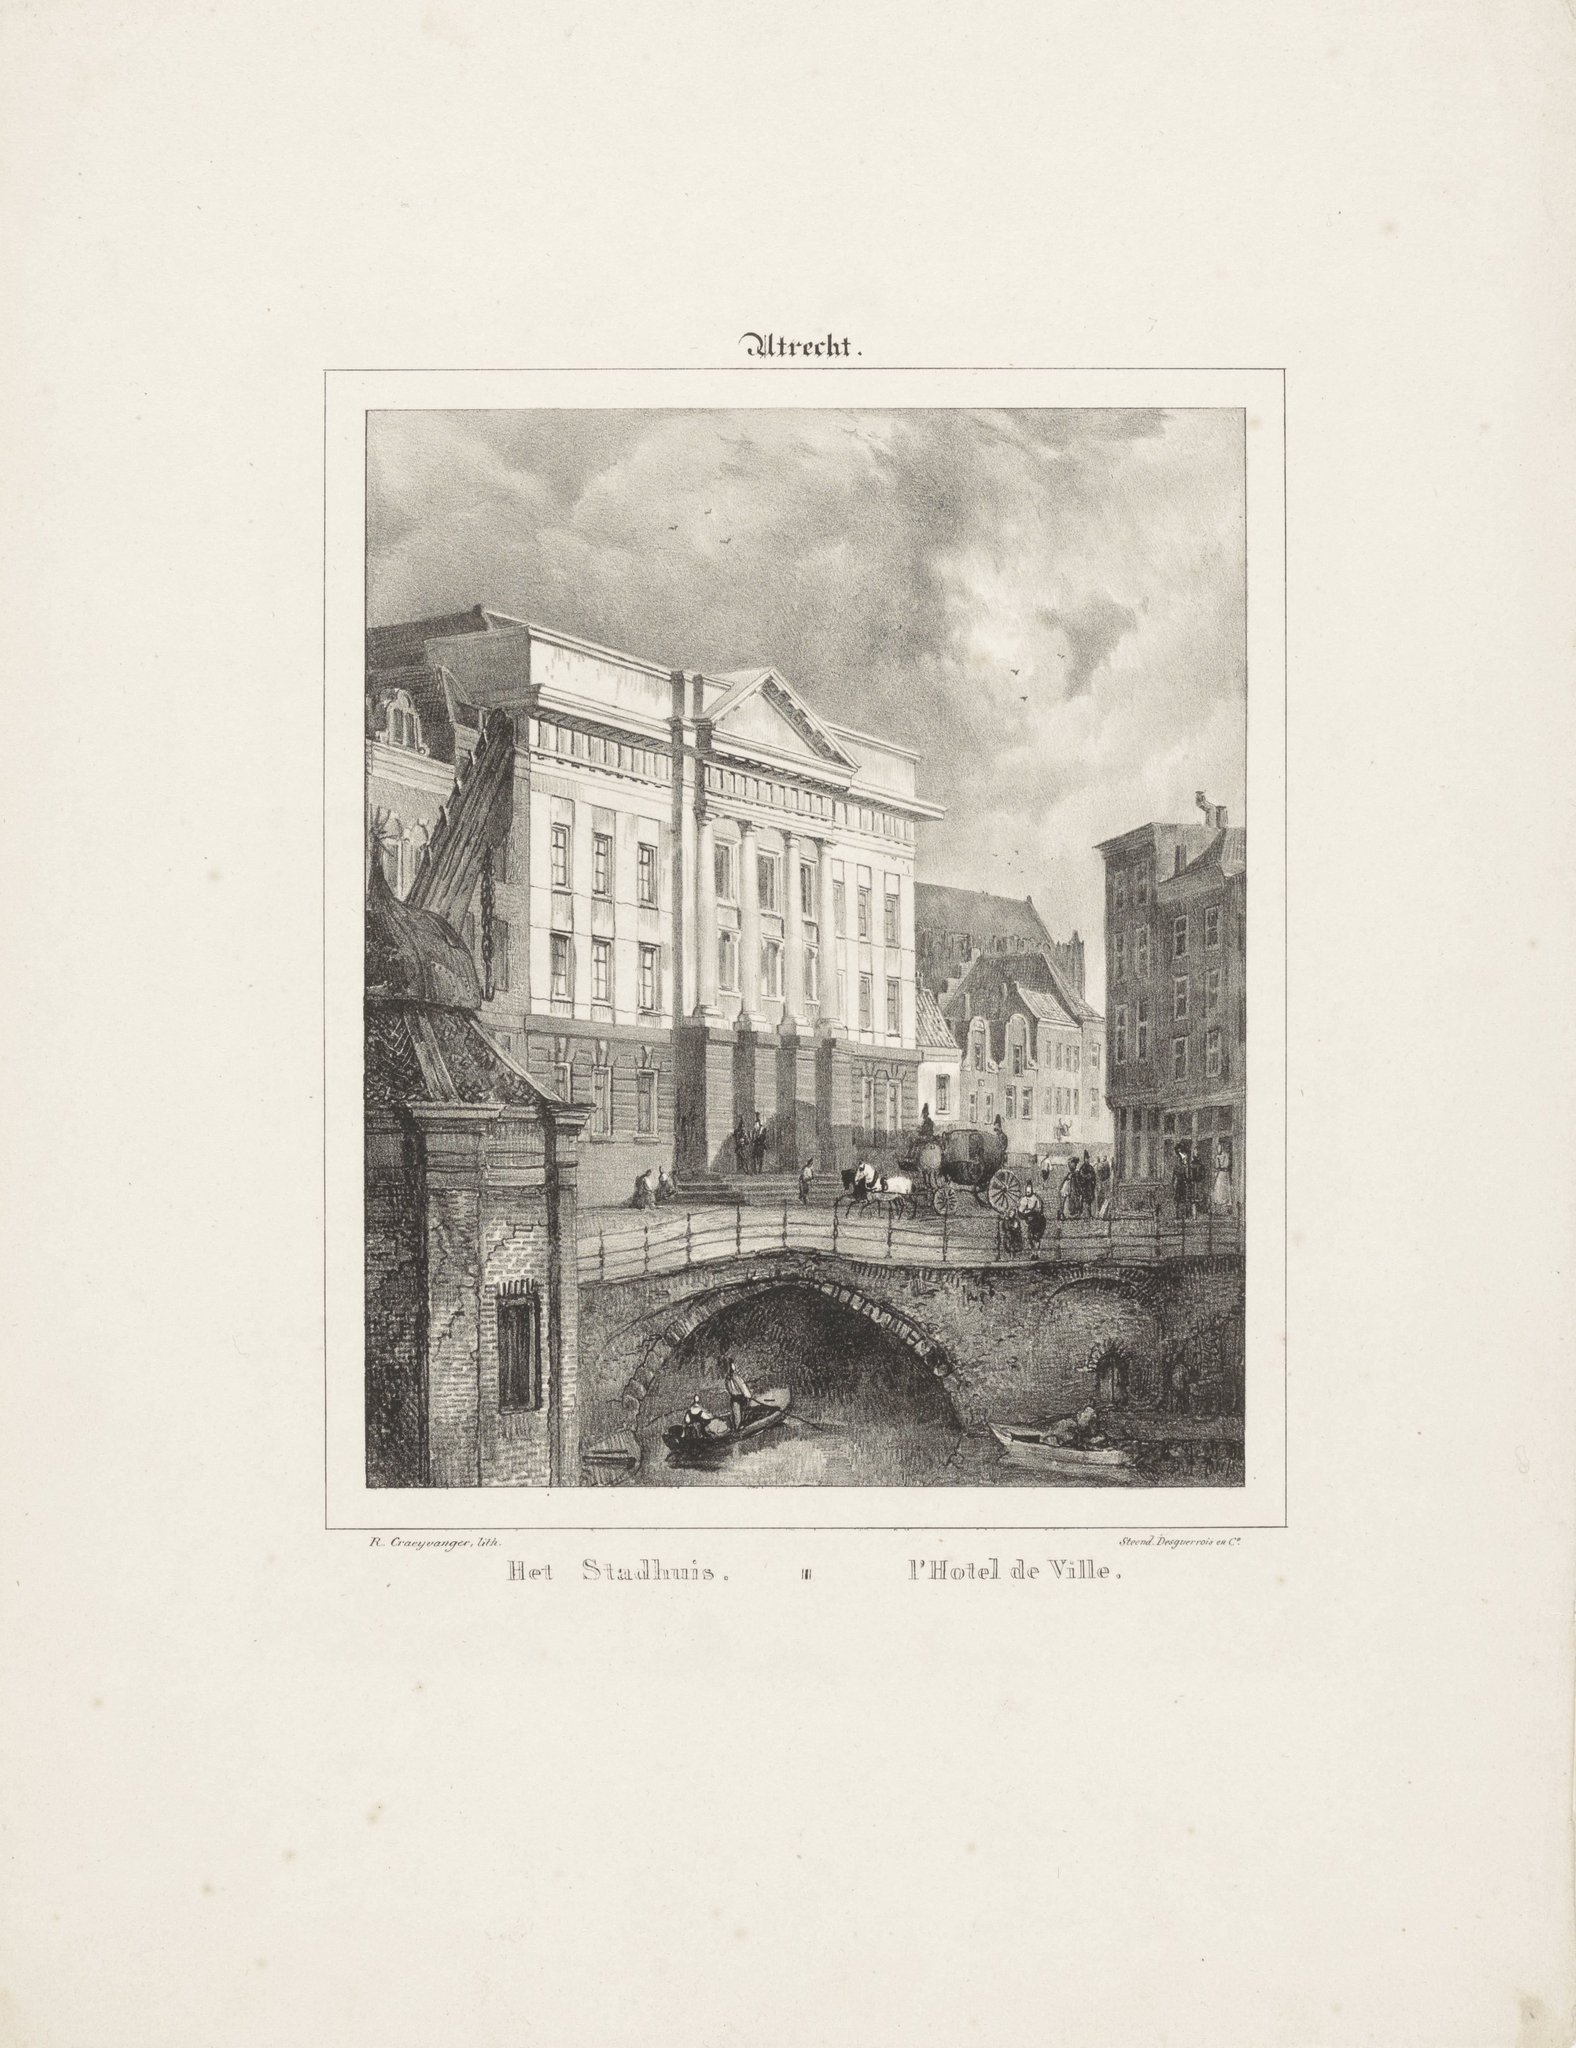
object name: print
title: Zes gezichten op Utrecht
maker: reinier craeyvanger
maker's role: draughtsman, print maker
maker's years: 1812-1880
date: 1830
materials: paper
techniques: lithograph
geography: amsterdam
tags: townhall, bridge in city across river, canal, etc., utrecht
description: Het stadhuis en de Stadhuisbrug zijn vanaf de Oudegracht gezien. Op het water varen boten, waarvan er een onder de brug gaat. Voor het stadhuis rijdt een rijtuig met twee paarden.